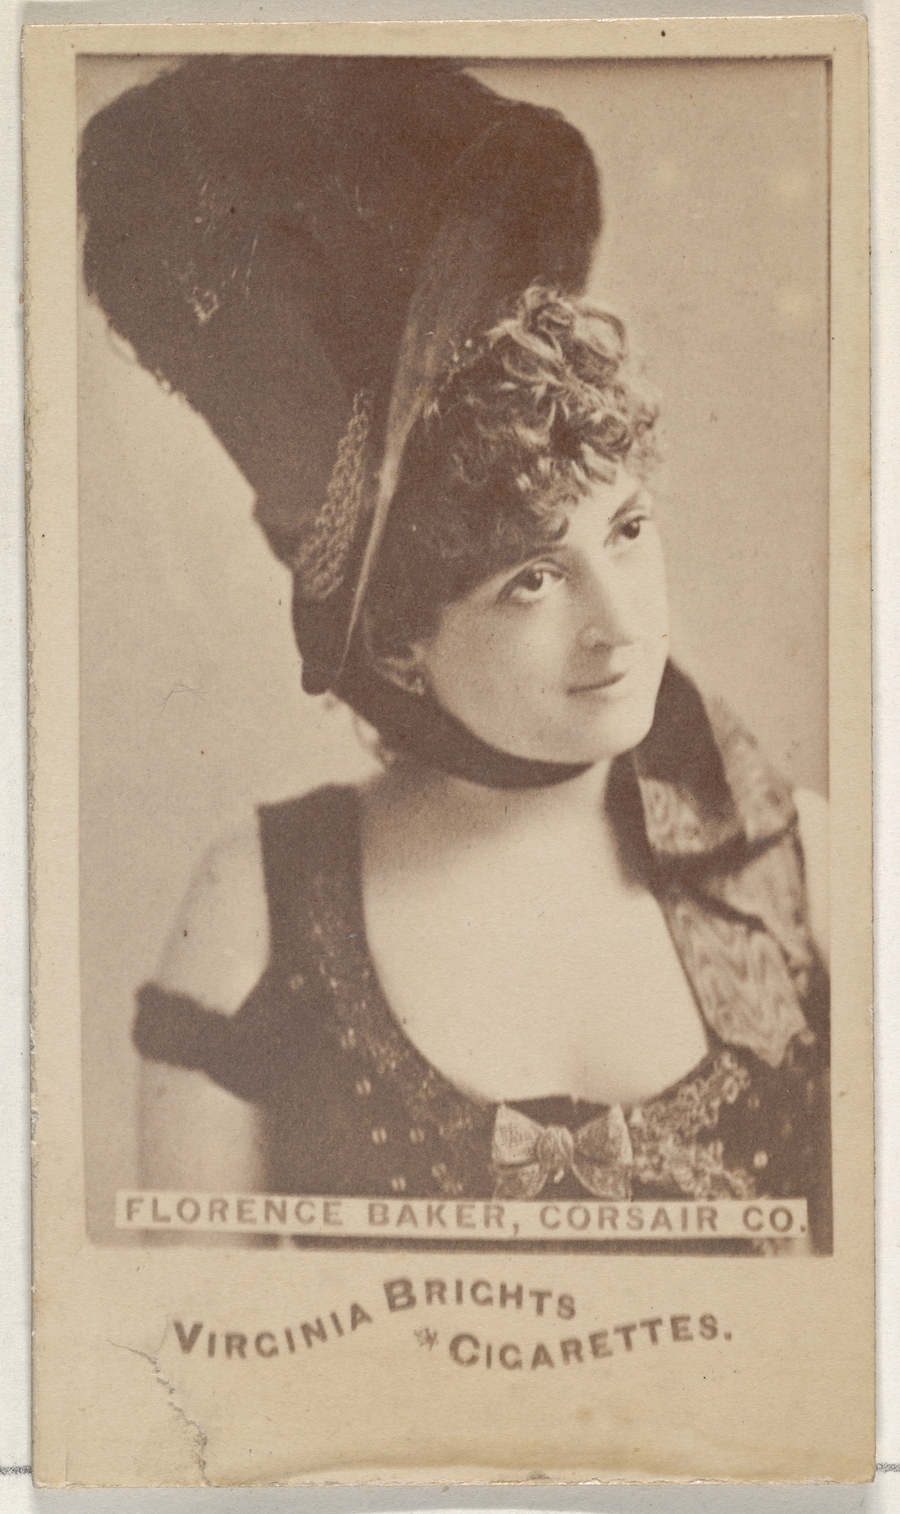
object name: photograph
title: Florence Baker, Corsair Co., from the Actors and Actresses series (N45, Type 6) for Virginia Brights Cigarettes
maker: allen & ginter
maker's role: publisher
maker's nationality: american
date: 1888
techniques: albumen silver print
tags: portraits,women,actresses